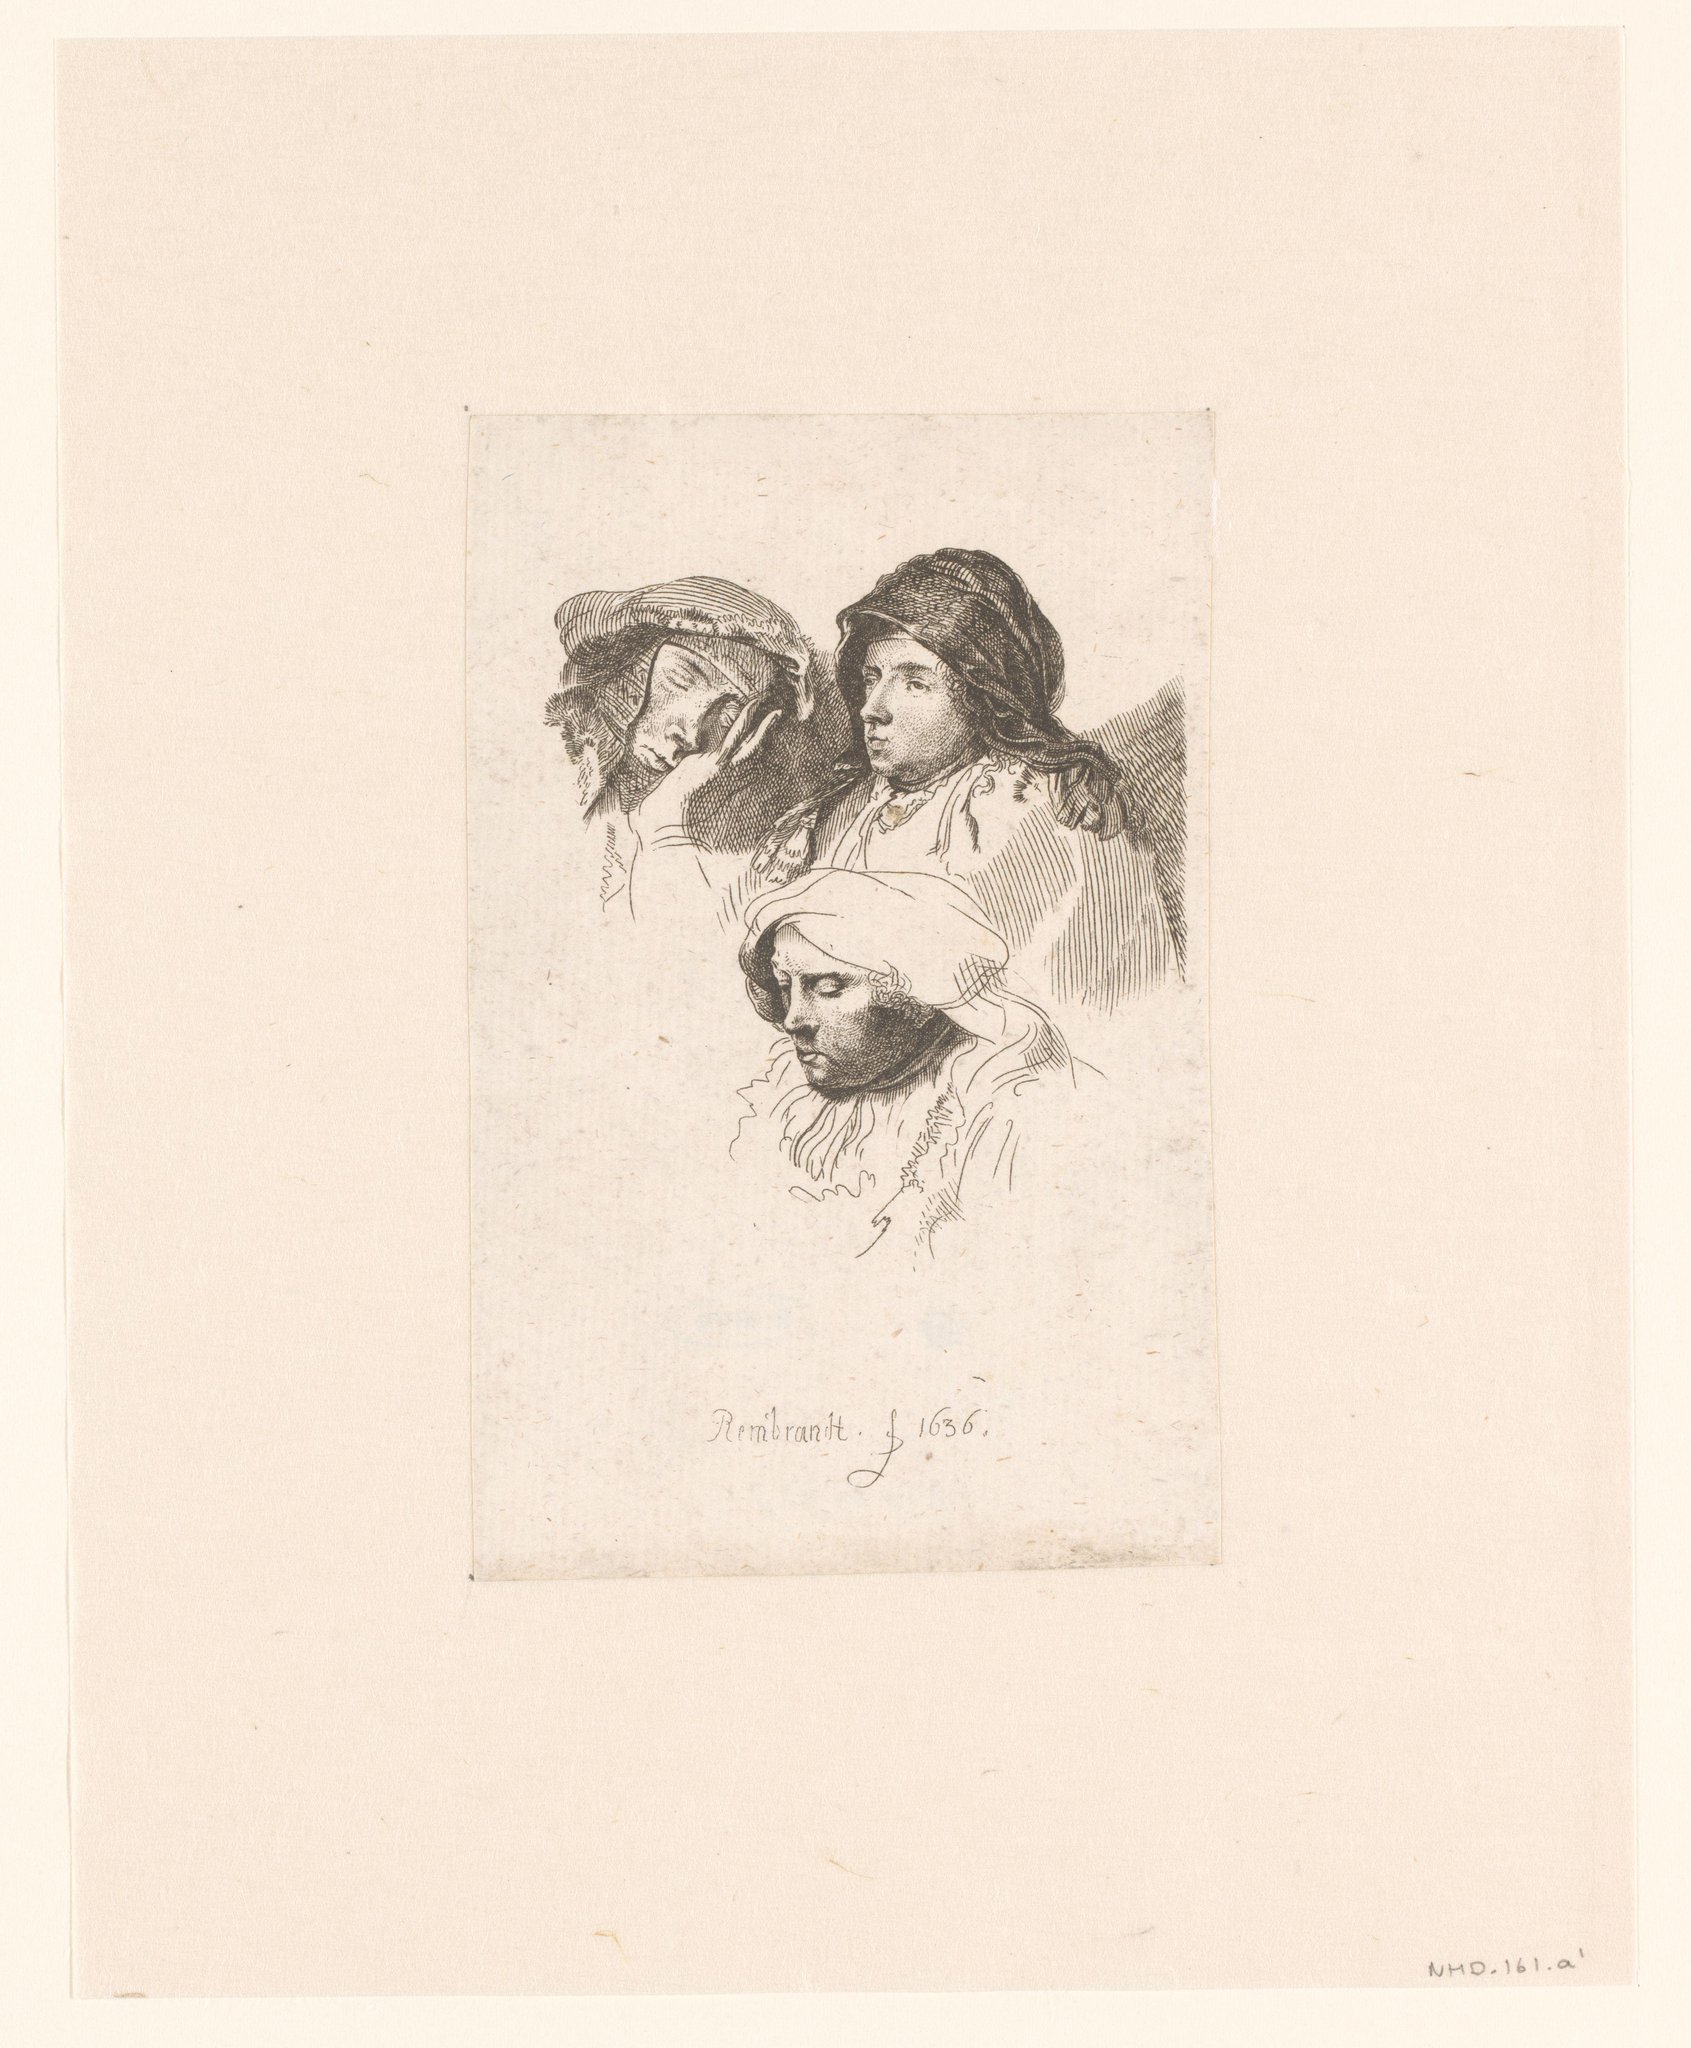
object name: print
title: Three heads of women: one asleep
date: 1711-1800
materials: paper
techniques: etching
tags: adult woman, sleeping; unconsciousness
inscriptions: collector's mark: Lugt 2228, collector's mark: Lugt 2760